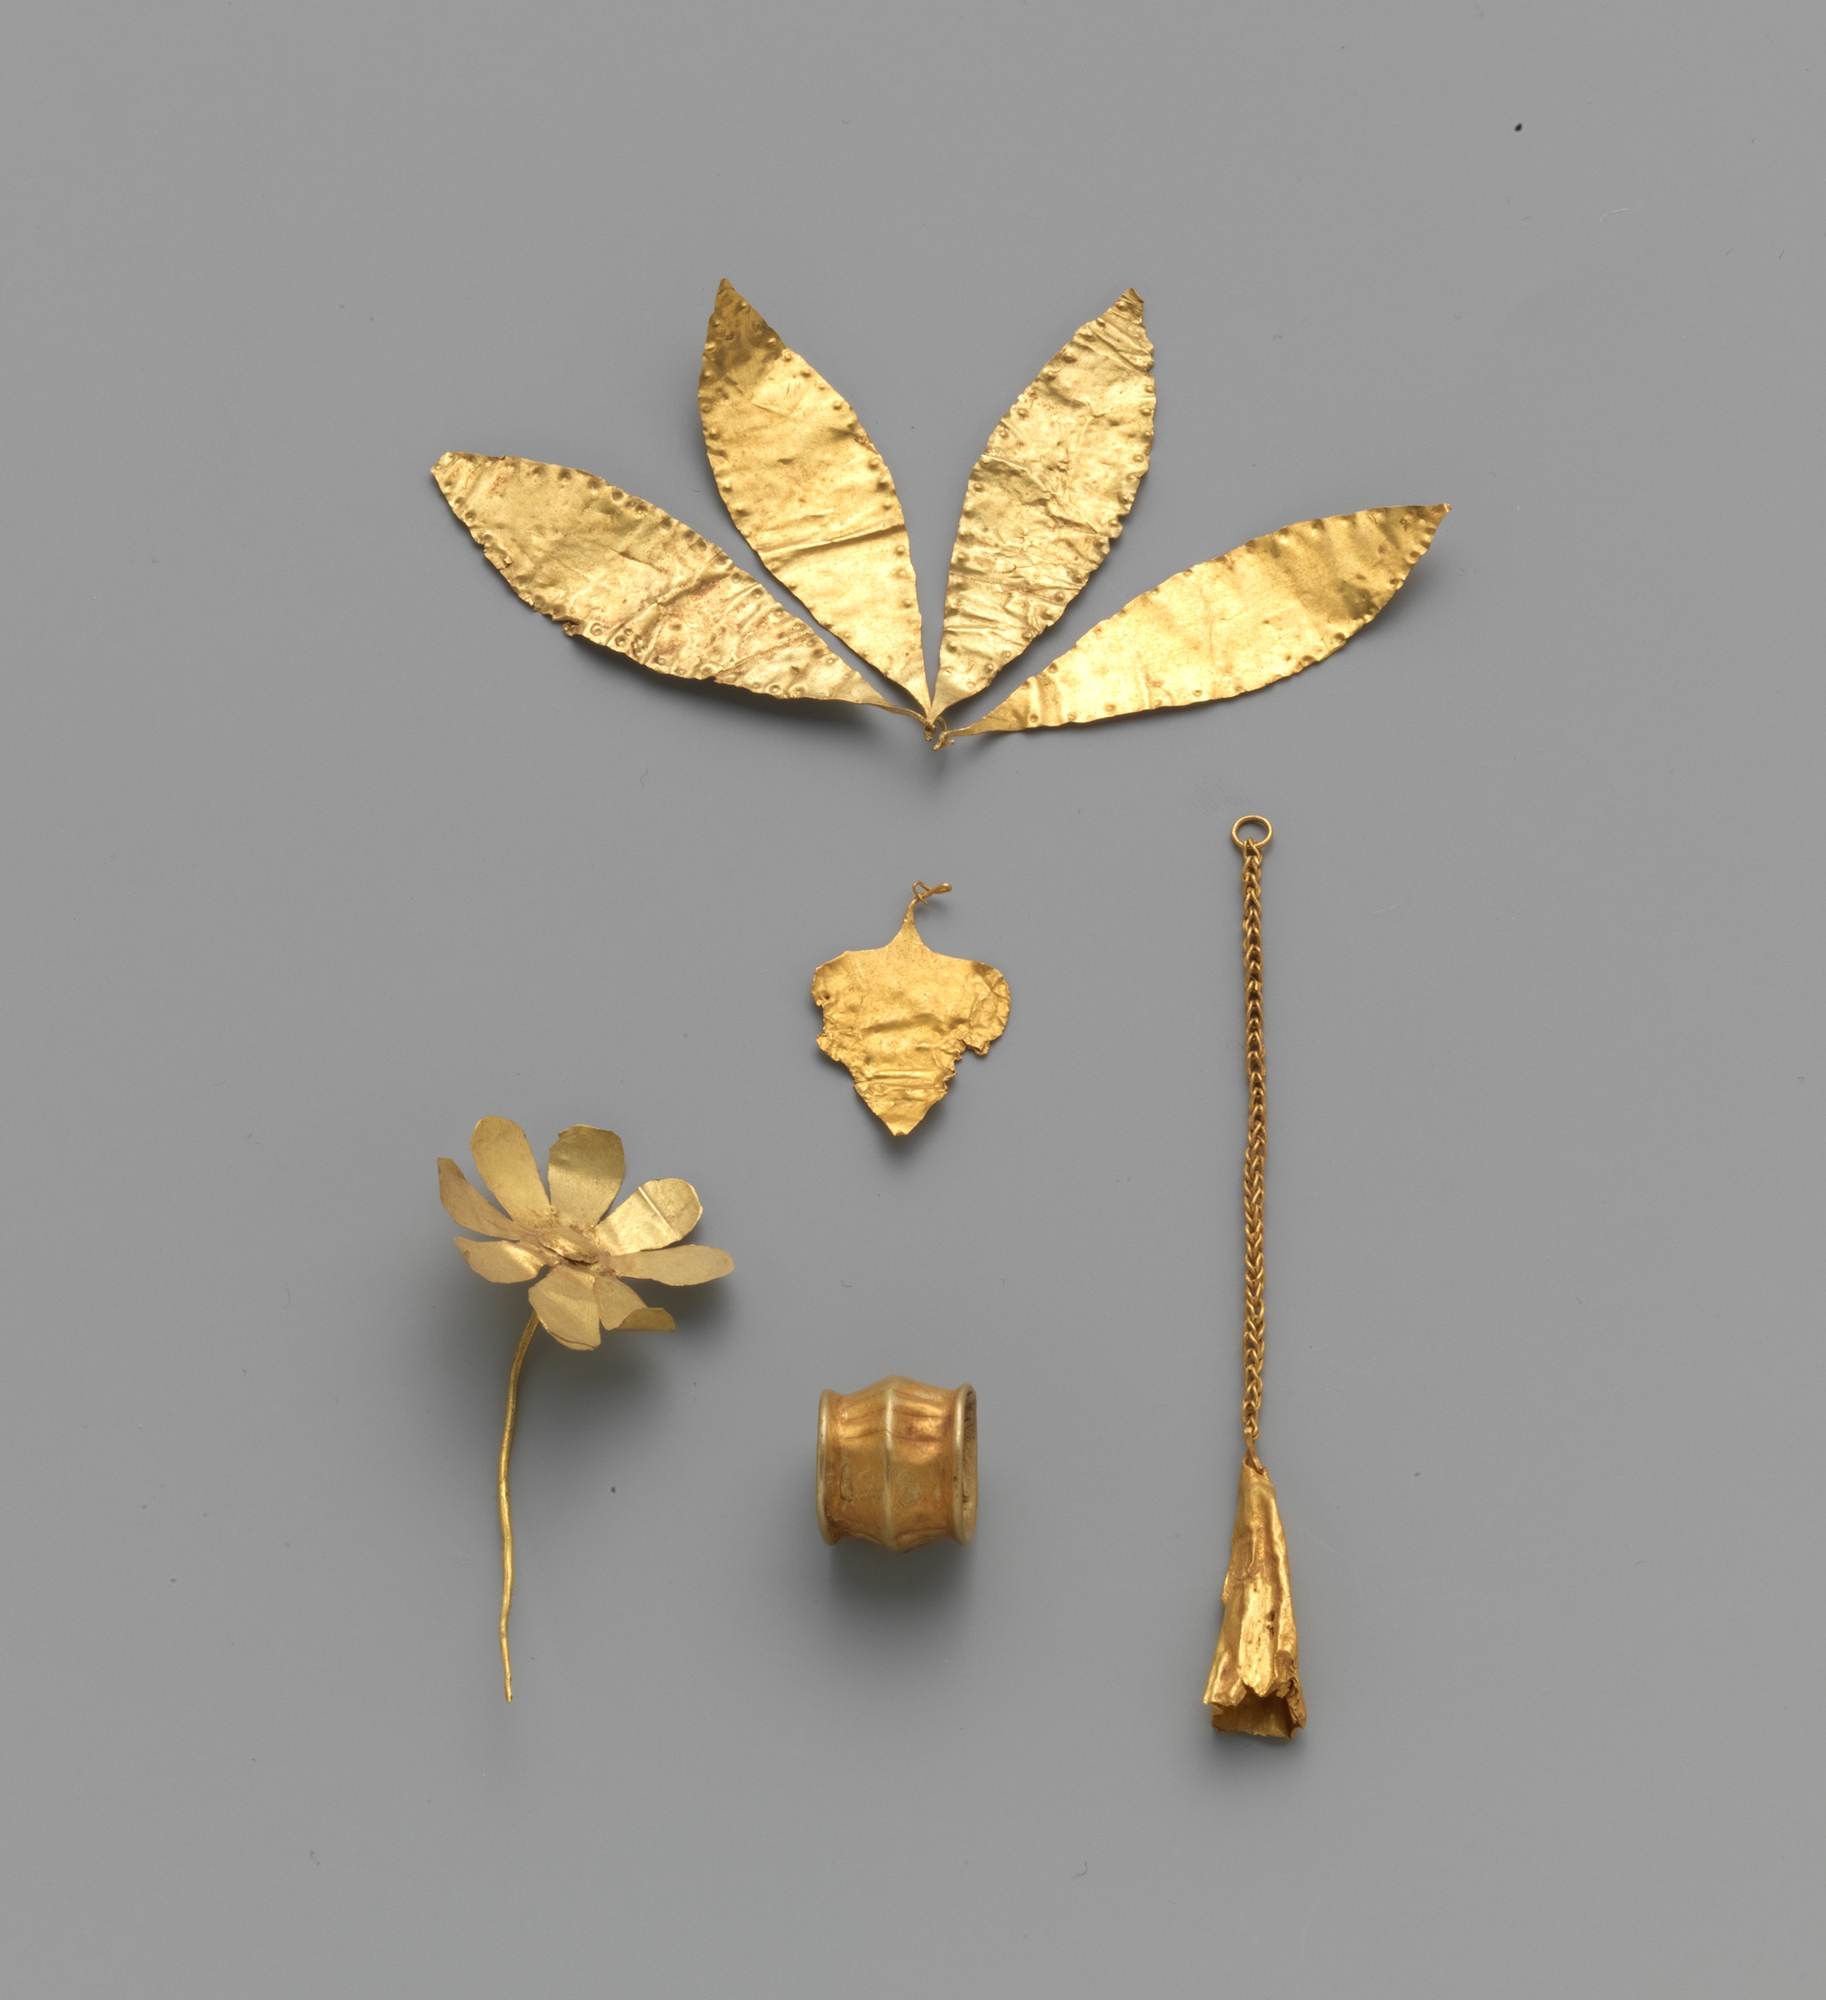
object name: pendant in the form of a leaf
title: Gold leaf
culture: minoan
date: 2300-2100 BCE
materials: gold